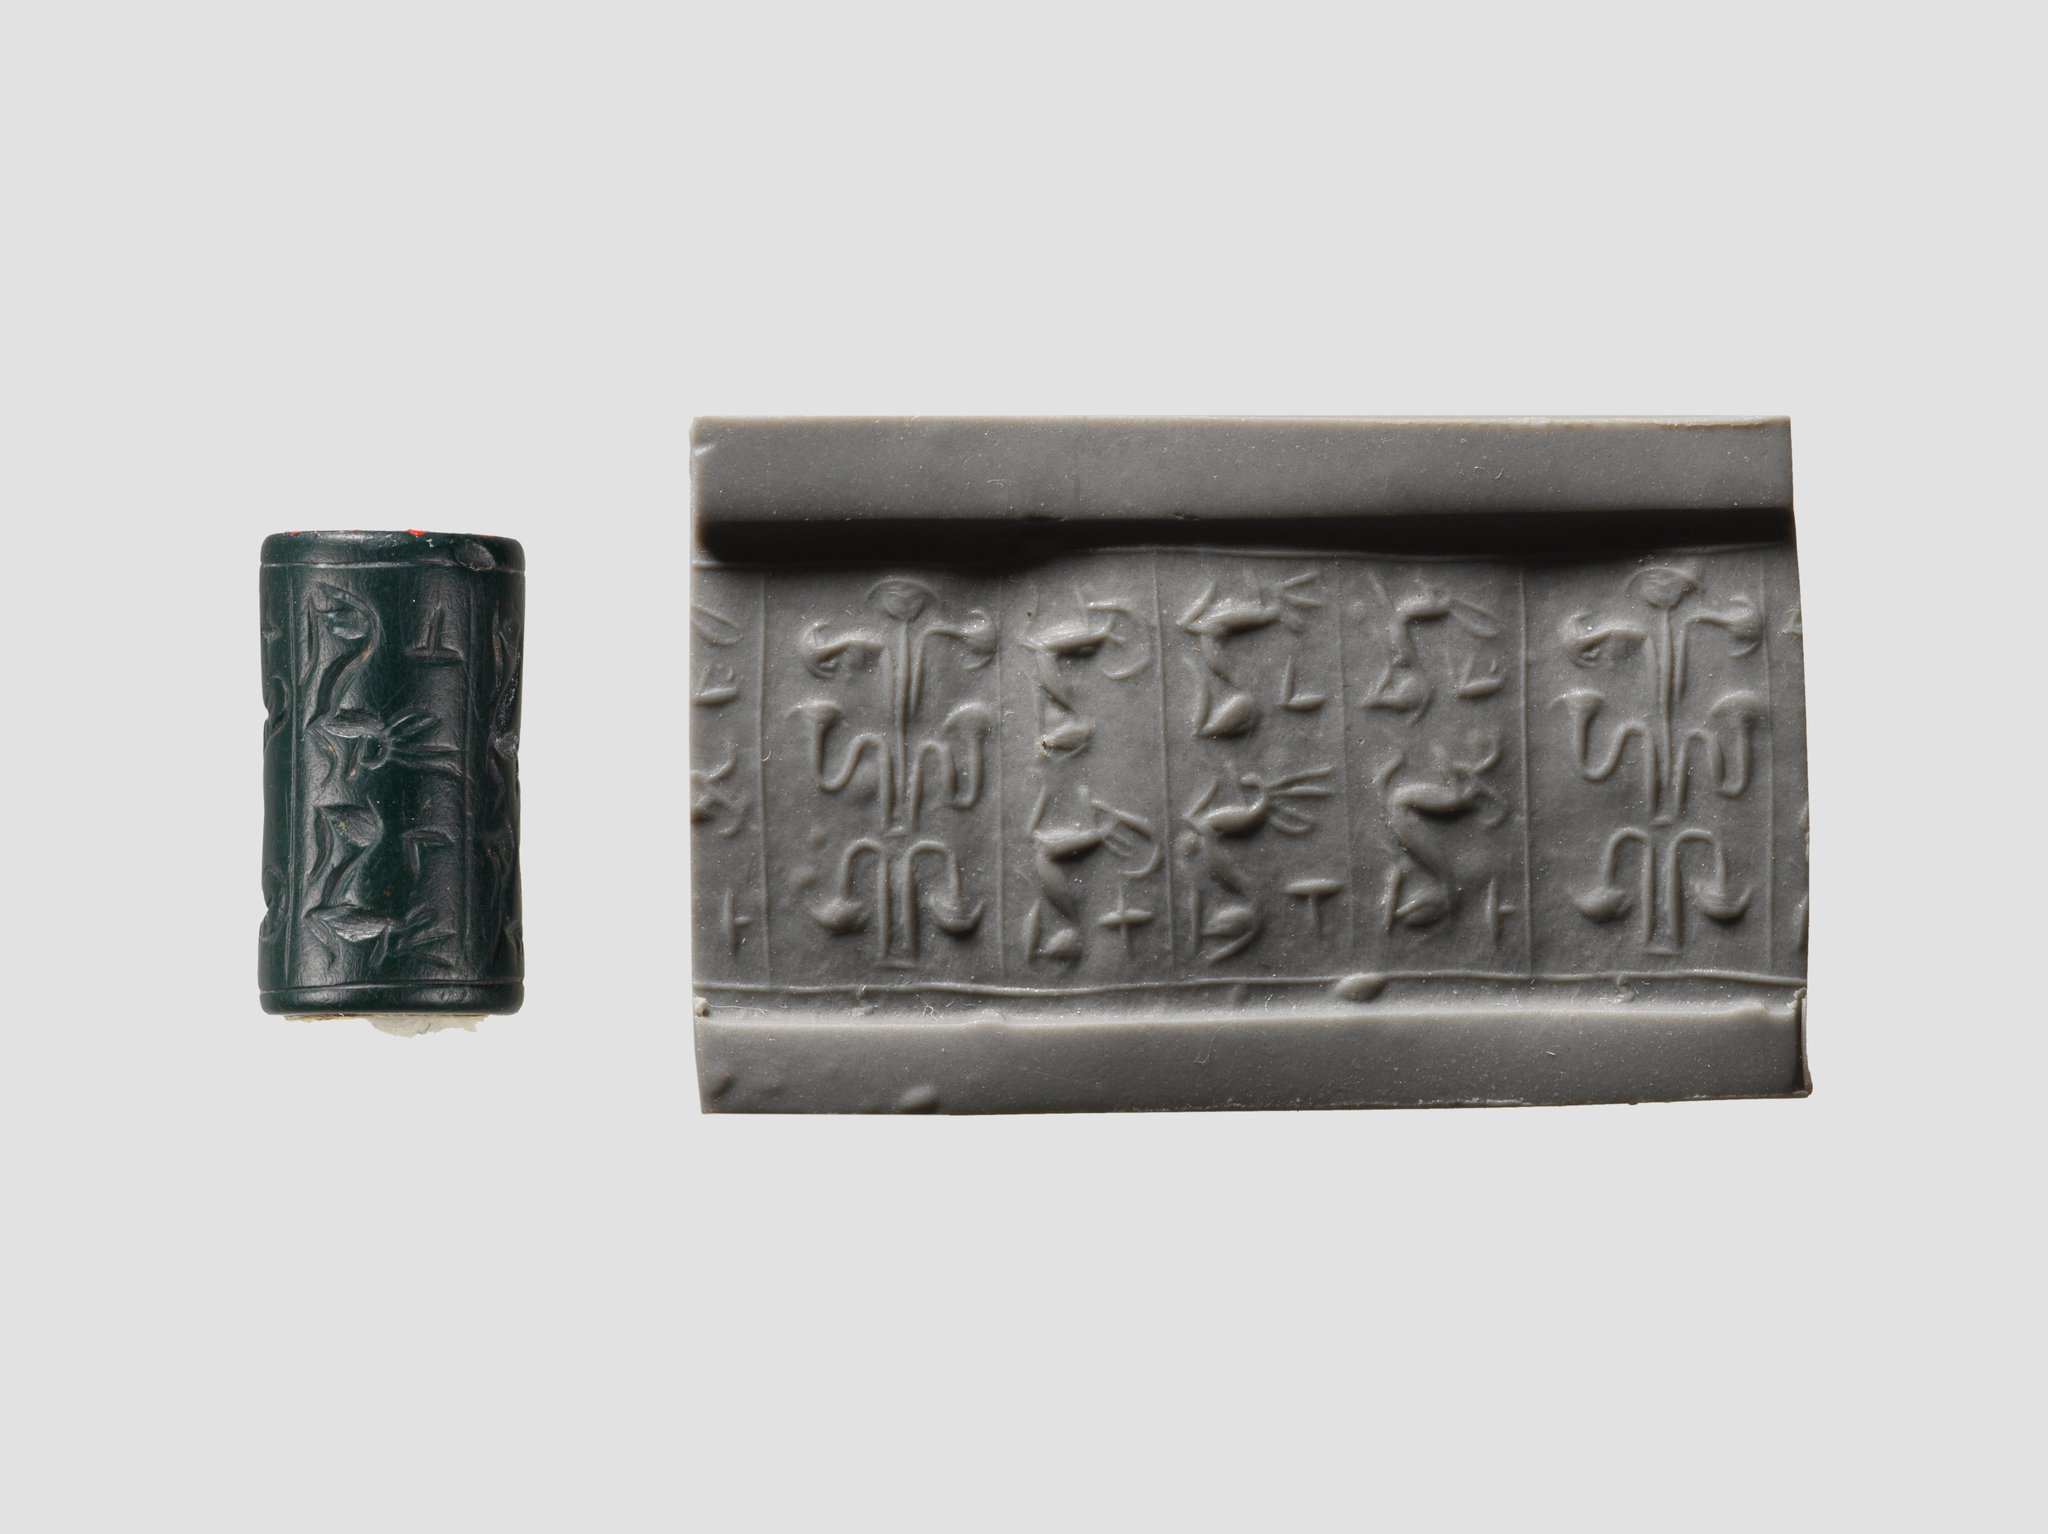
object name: cylinder seal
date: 2000-1668 BCE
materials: jasper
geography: syria